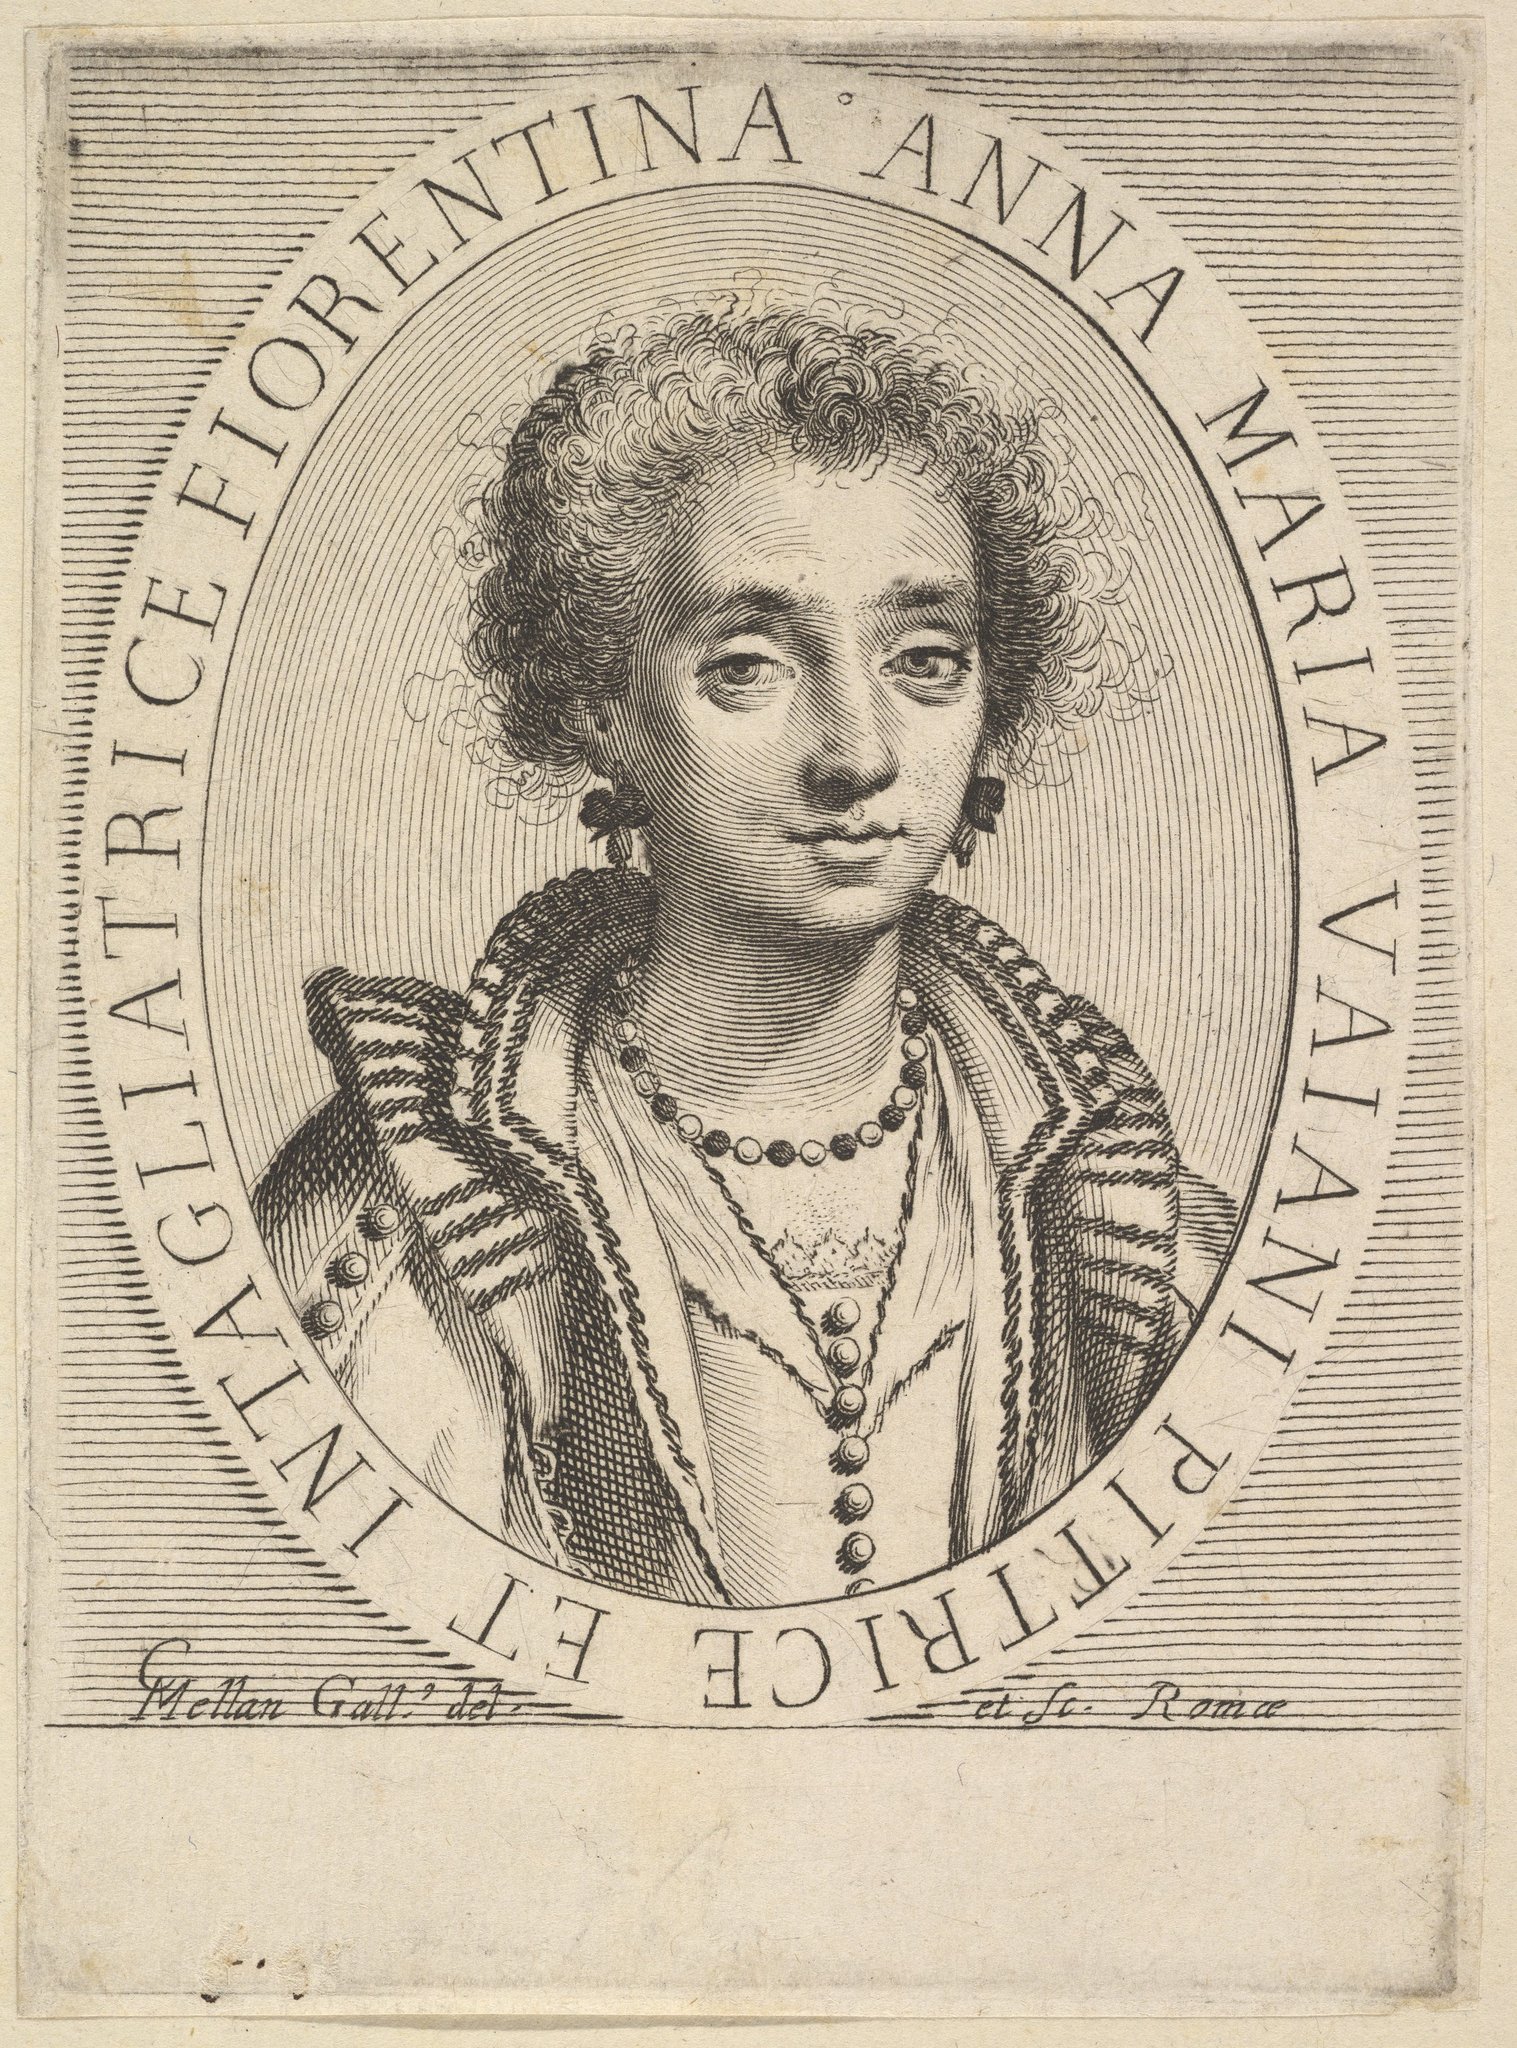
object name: print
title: Anna Maria Vaiani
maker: claude mellan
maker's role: artist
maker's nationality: french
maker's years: 1598-1688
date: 1624-1636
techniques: engraving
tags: portraits,women